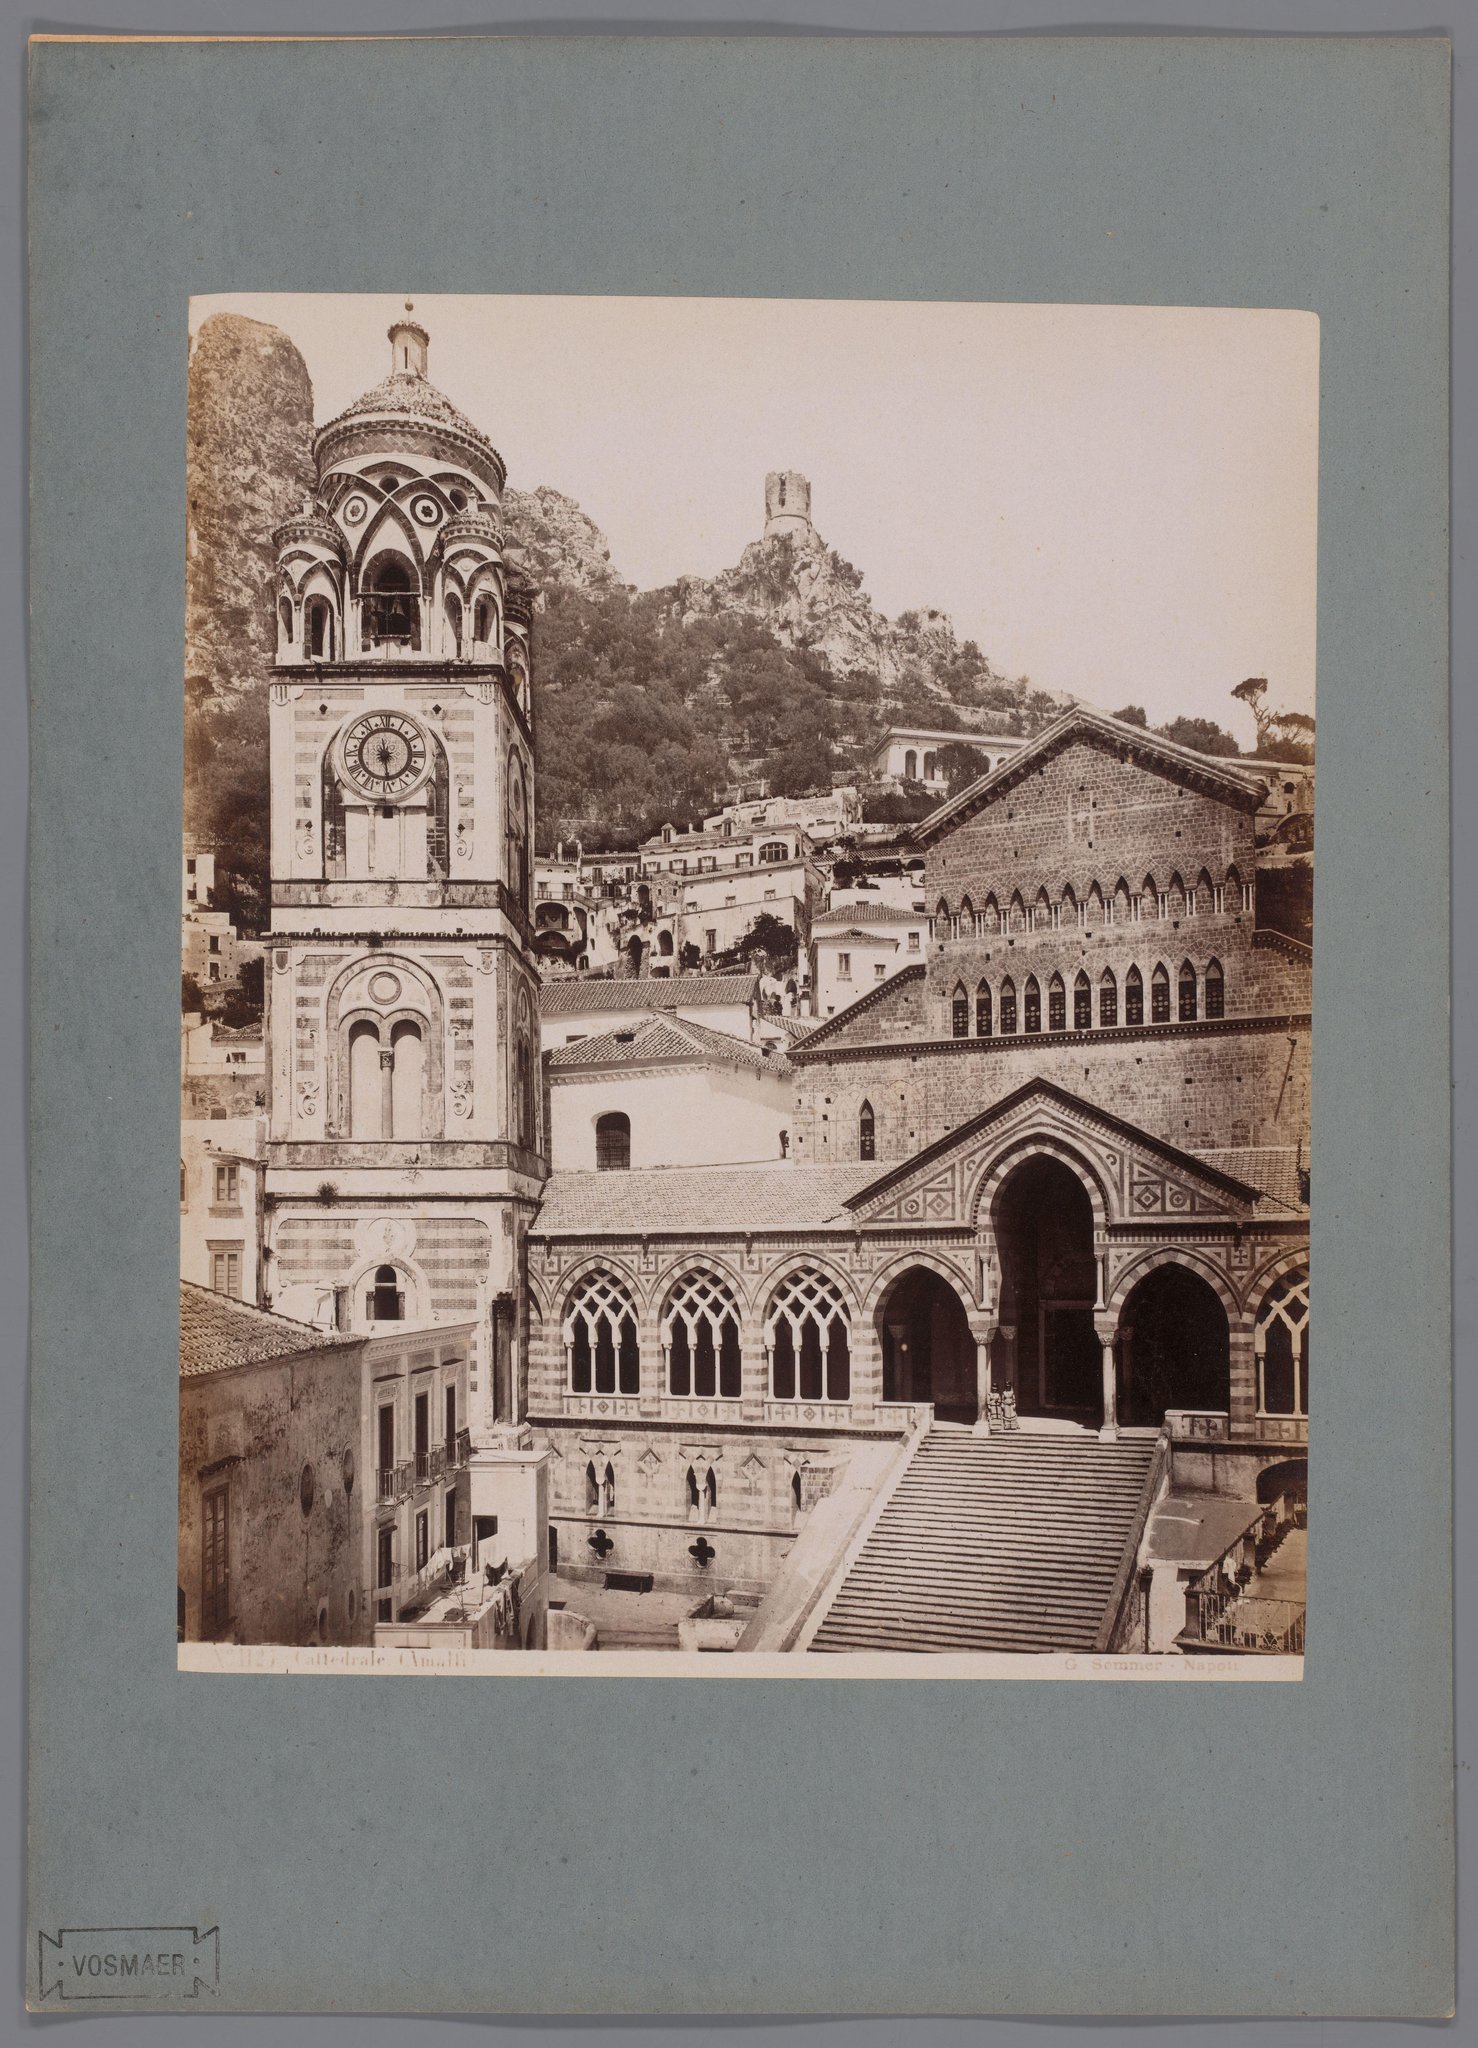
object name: photograph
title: Cattedrale (Amalfi)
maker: giorgio sommer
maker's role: fotograaf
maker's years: 1834-1914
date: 1857-1914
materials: cardboard, paper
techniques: albumen print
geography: amalfi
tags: abbey, monastery, convent ~ roman catholic church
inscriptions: number: ‘No. 1125’, collector's mark: ‘VOSMAER’